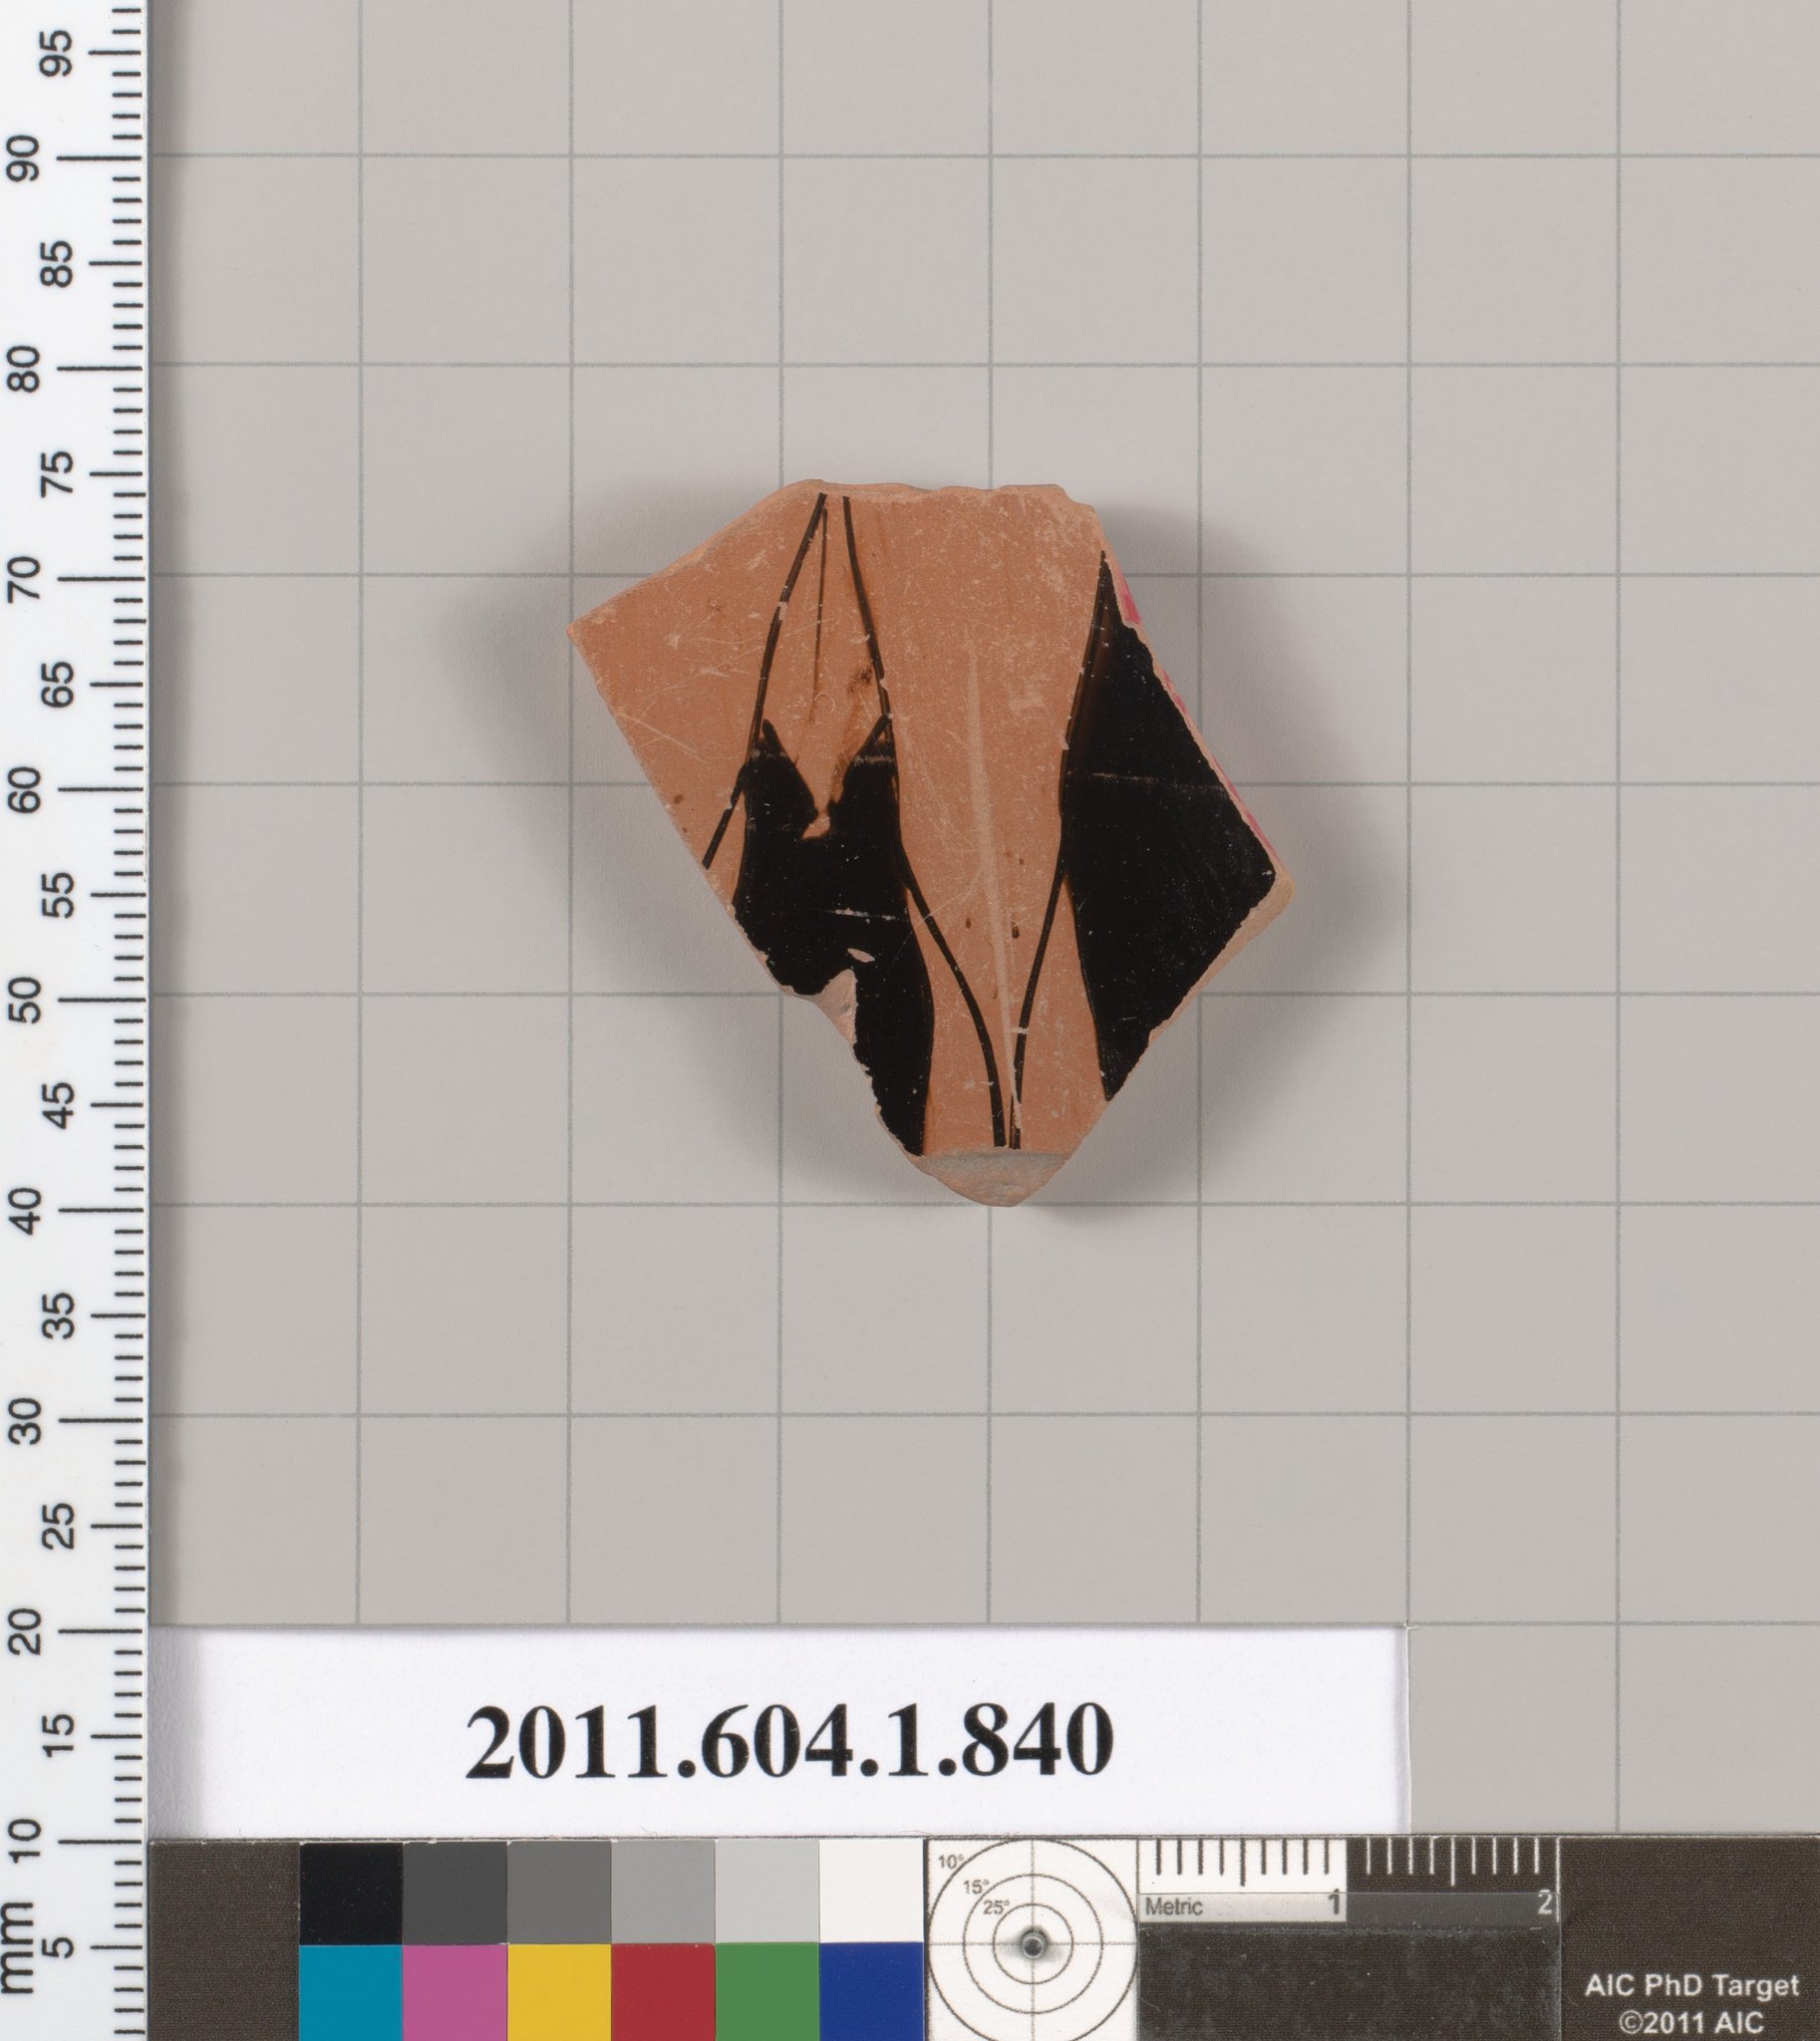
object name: kylix fragment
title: Terracotta fragment of a kylix (drinking cup)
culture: greek, attic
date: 475-451 BCE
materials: terracotta